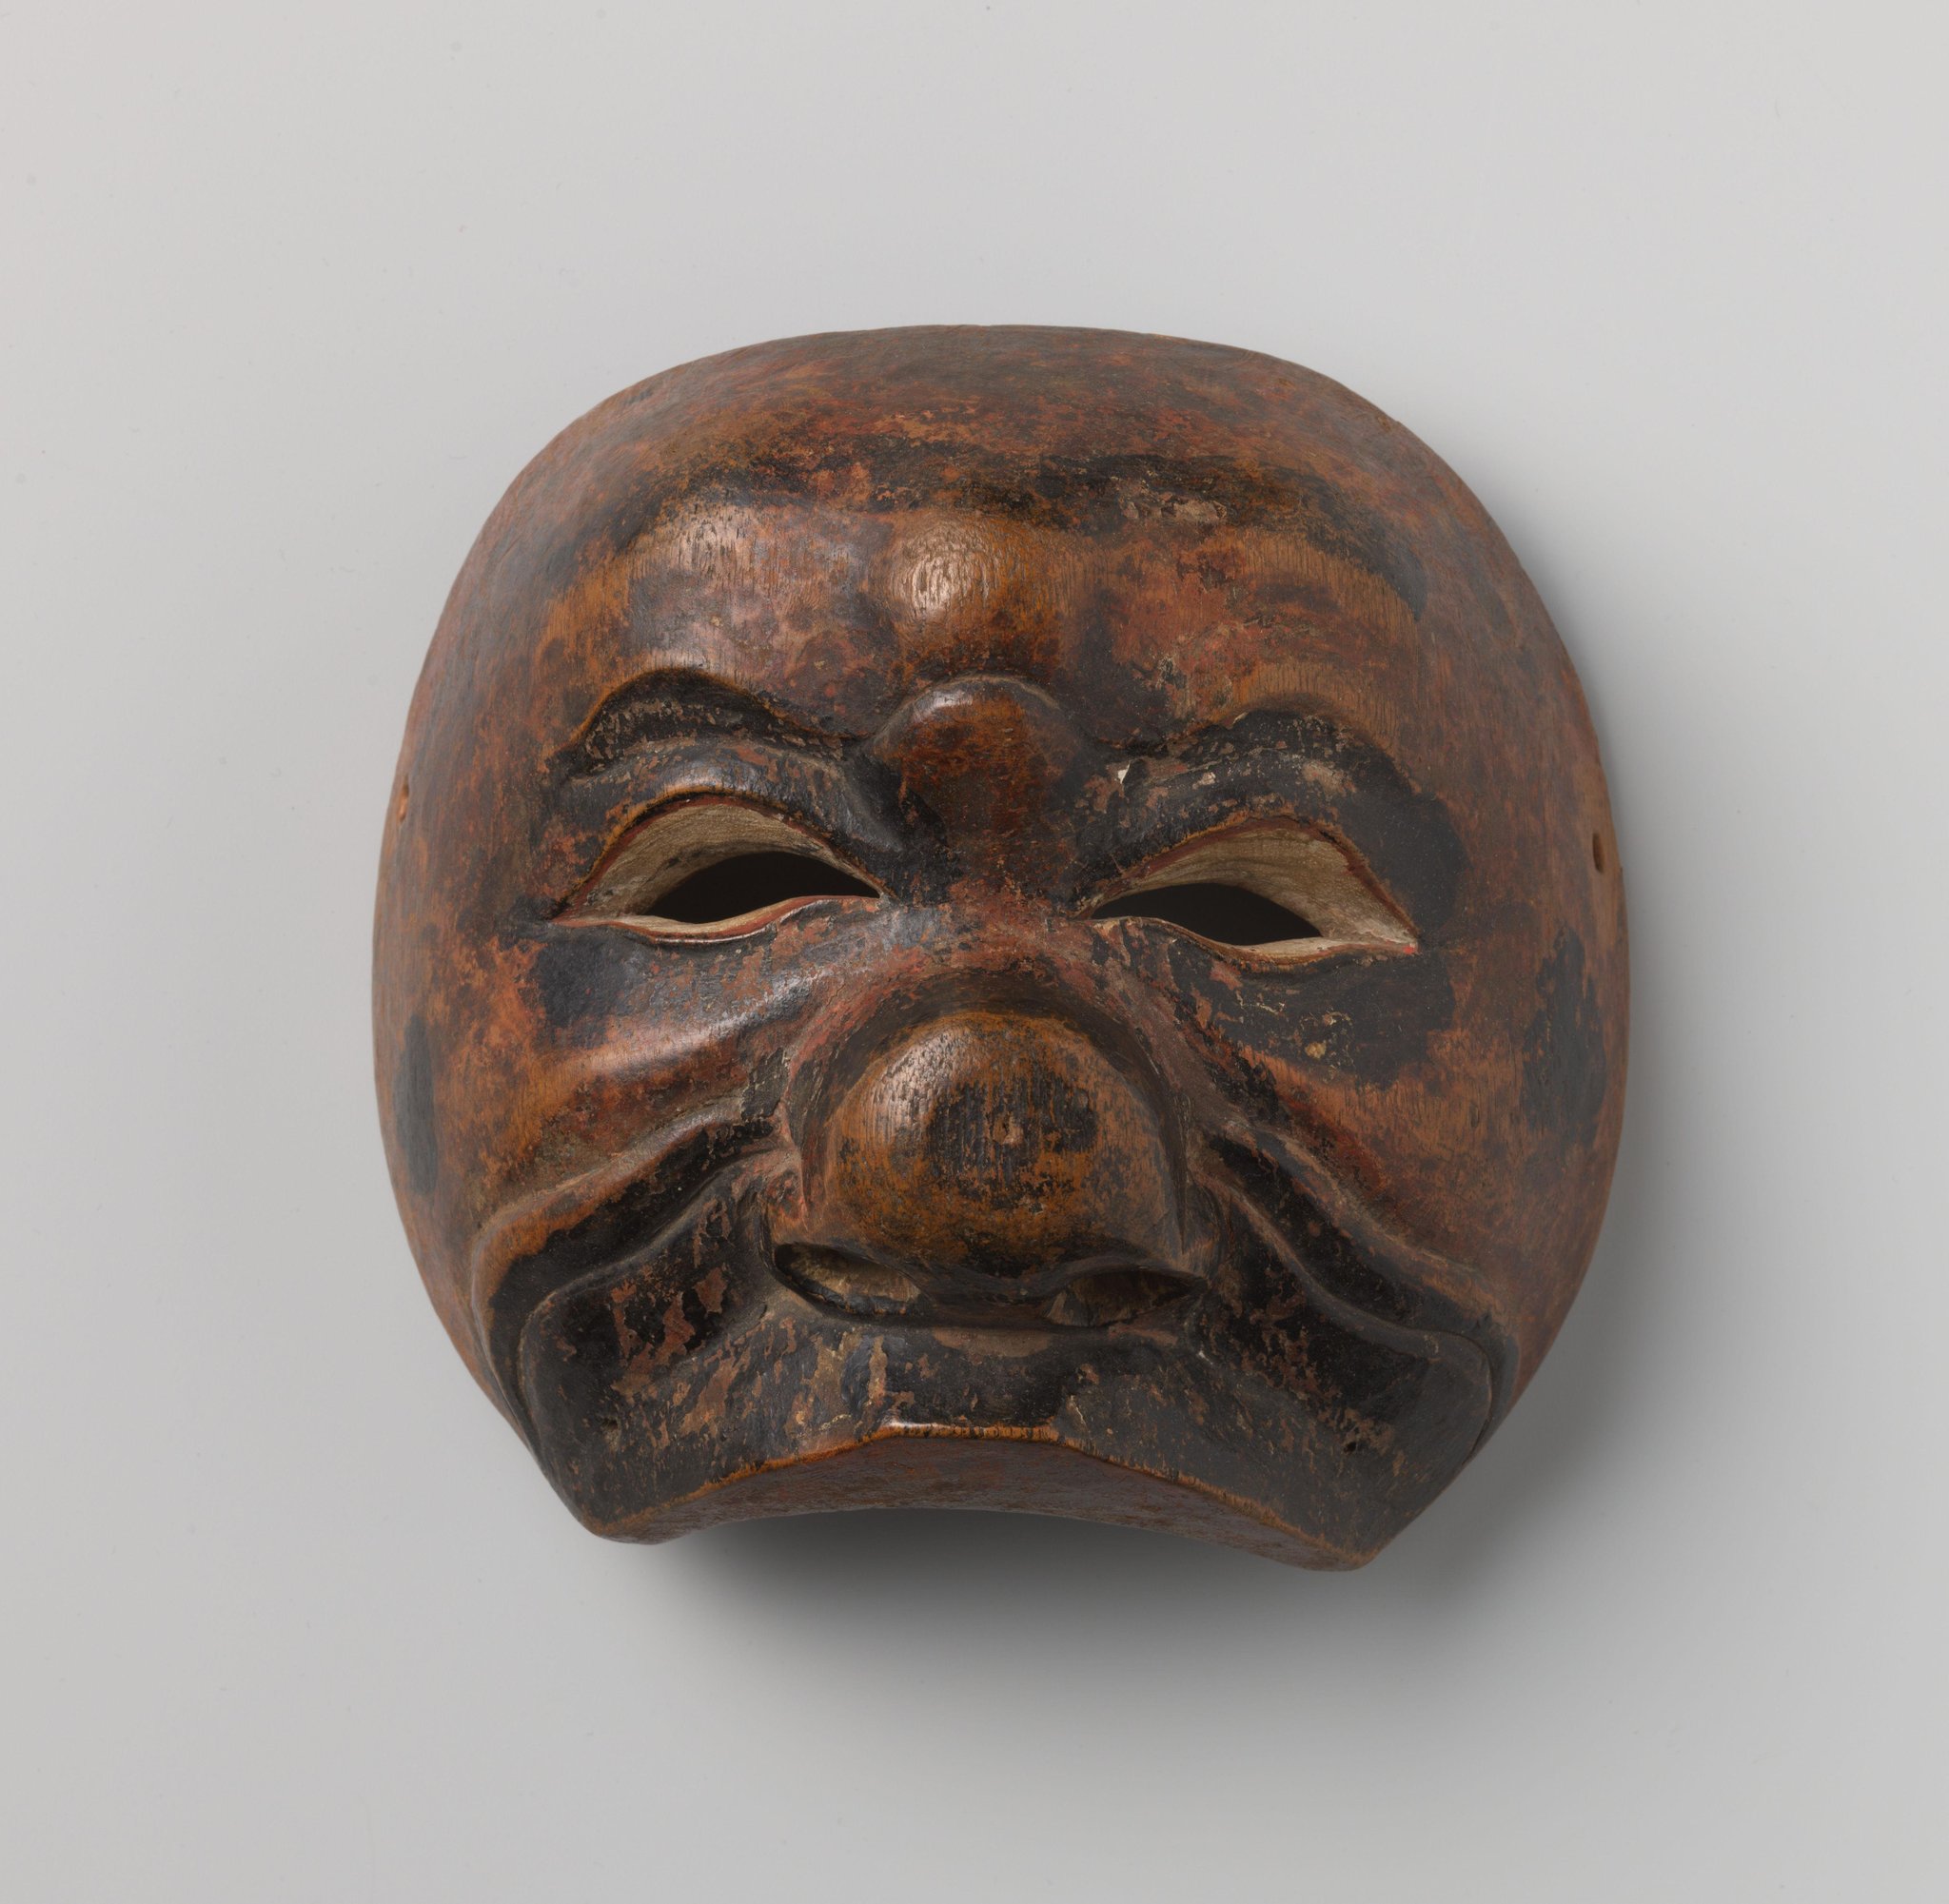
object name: mask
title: Masker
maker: Anonymous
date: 1800-1900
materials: dye, wood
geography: java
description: Houten masker met sporen van polychromie. Het is het masker van Pentul/Pepentul. De oudste dienaar van de held Panji. De onderkaak hoort afwezig te zijn.